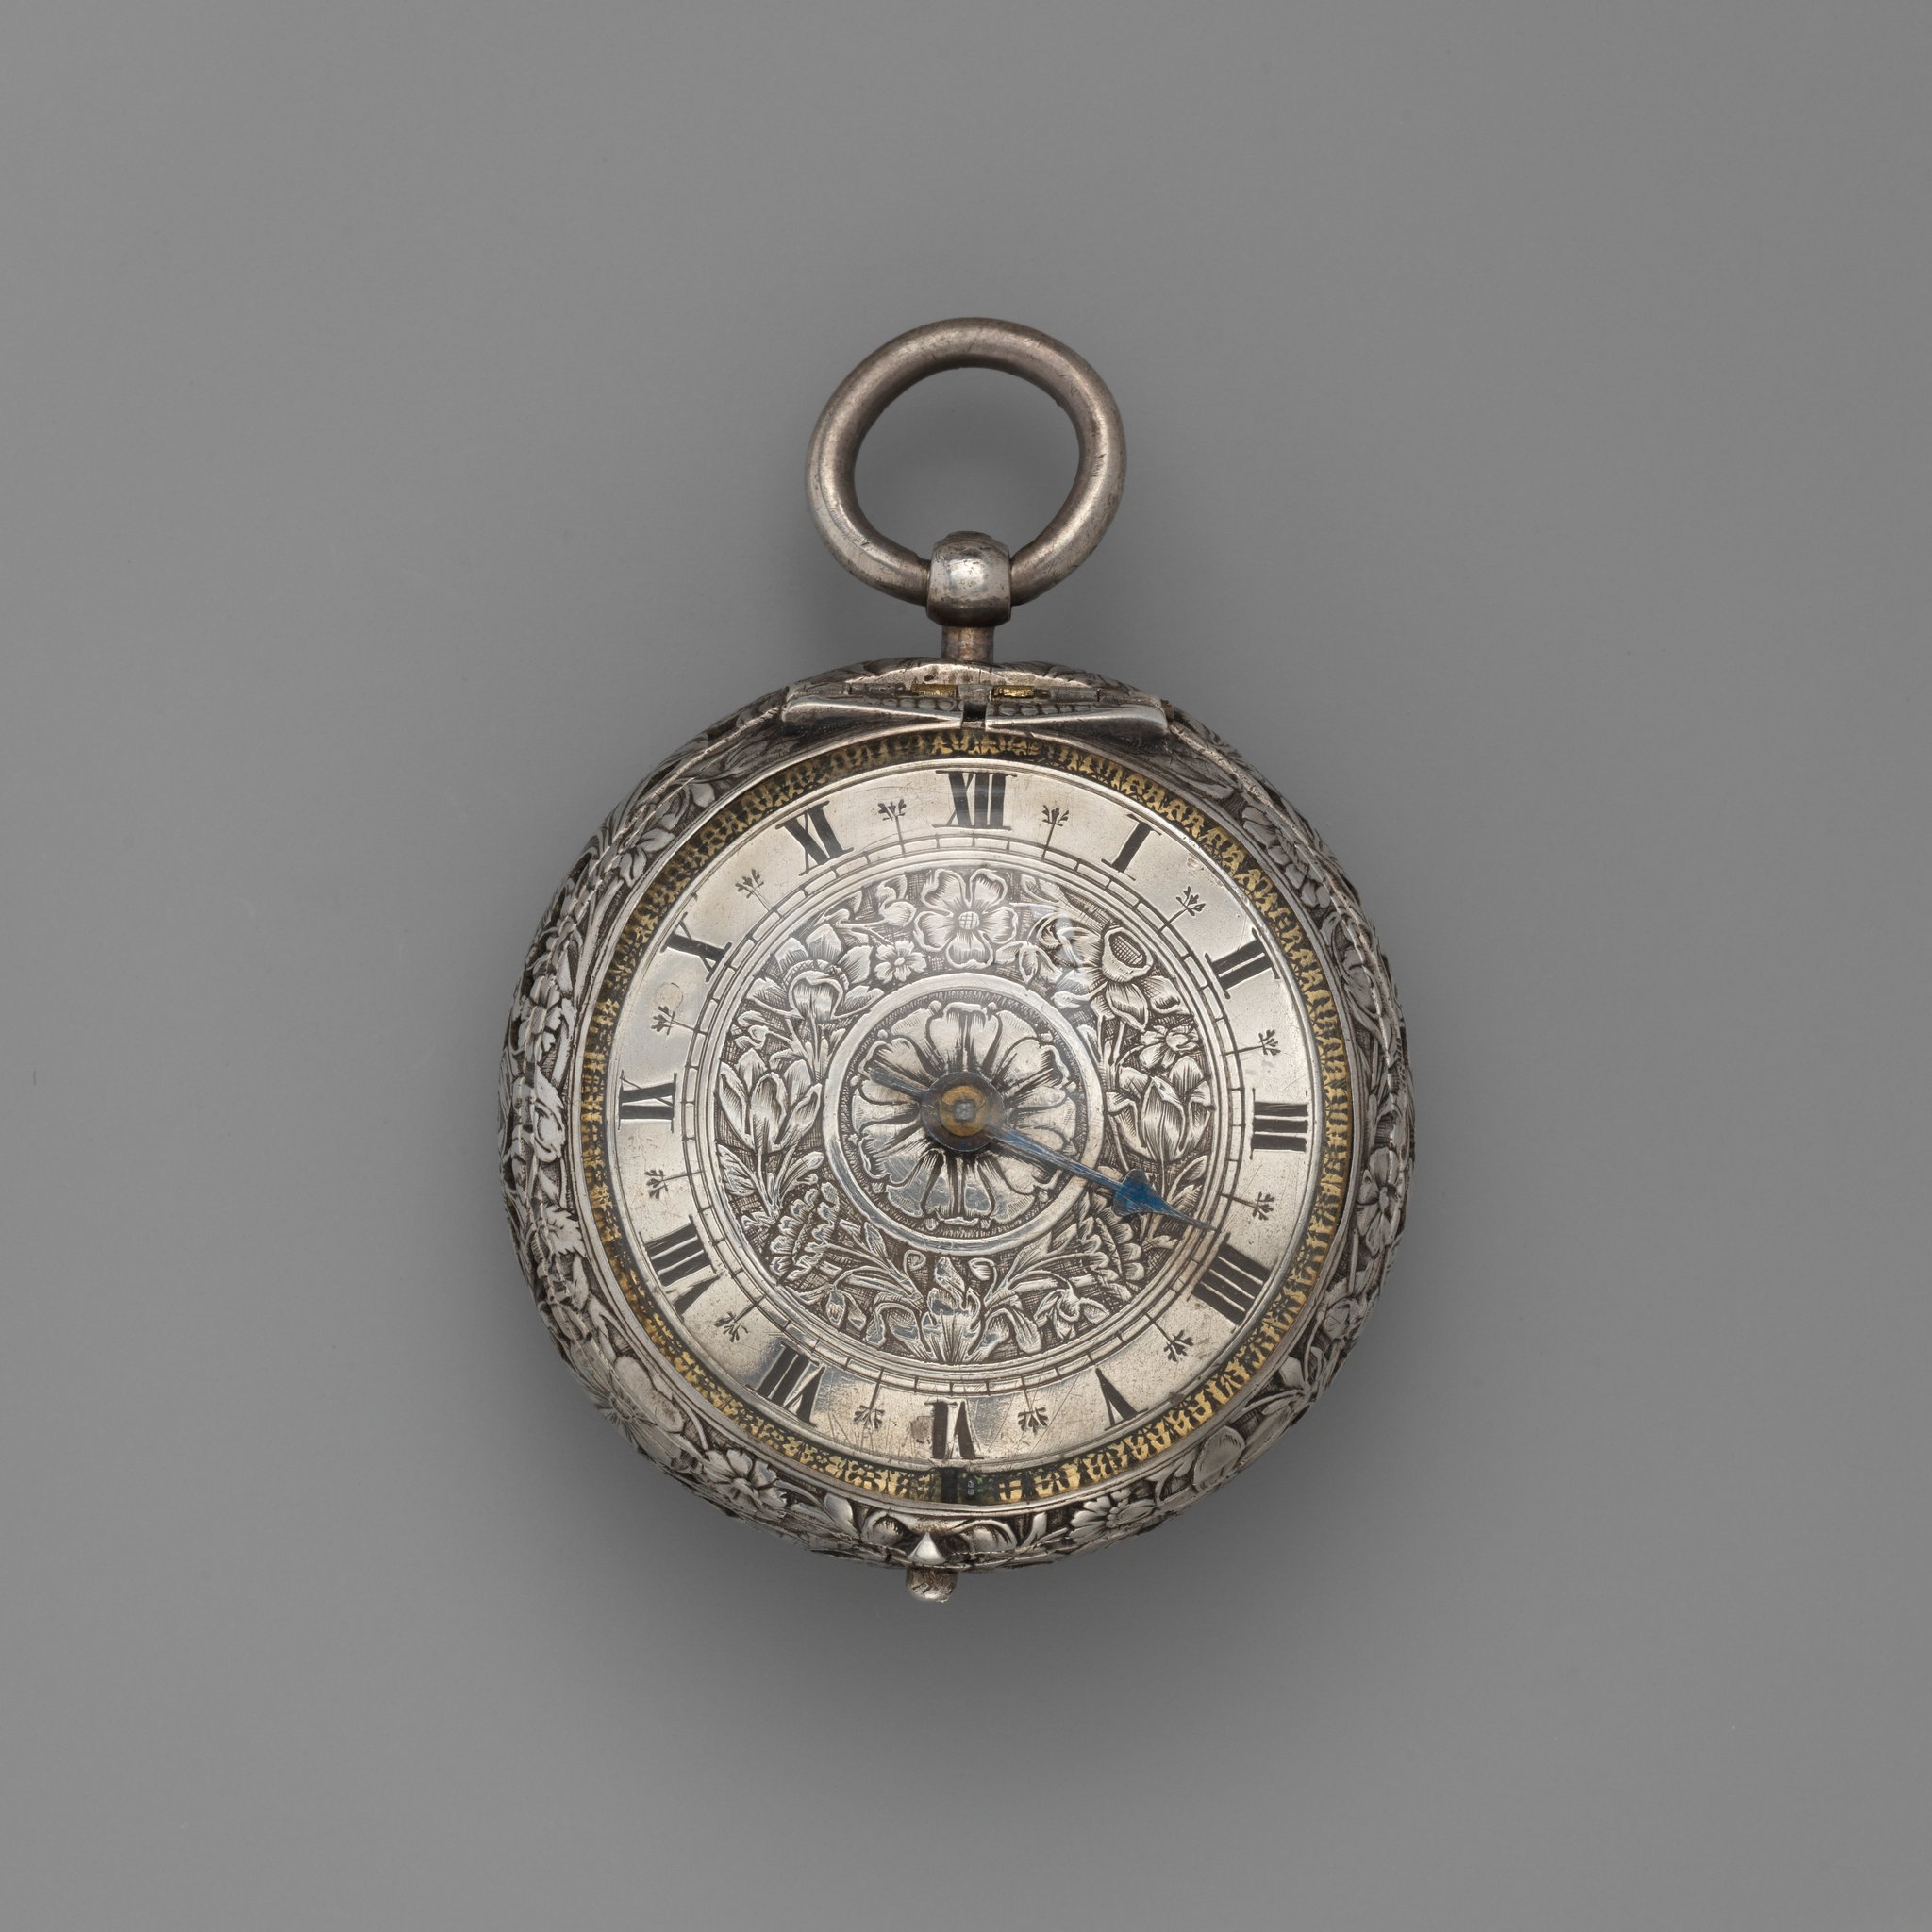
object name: clock watch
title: Clock-watch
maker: jeremie gregorie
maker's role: maker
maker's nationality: british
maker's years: 1585-1685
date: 1670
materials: silver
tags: flowers